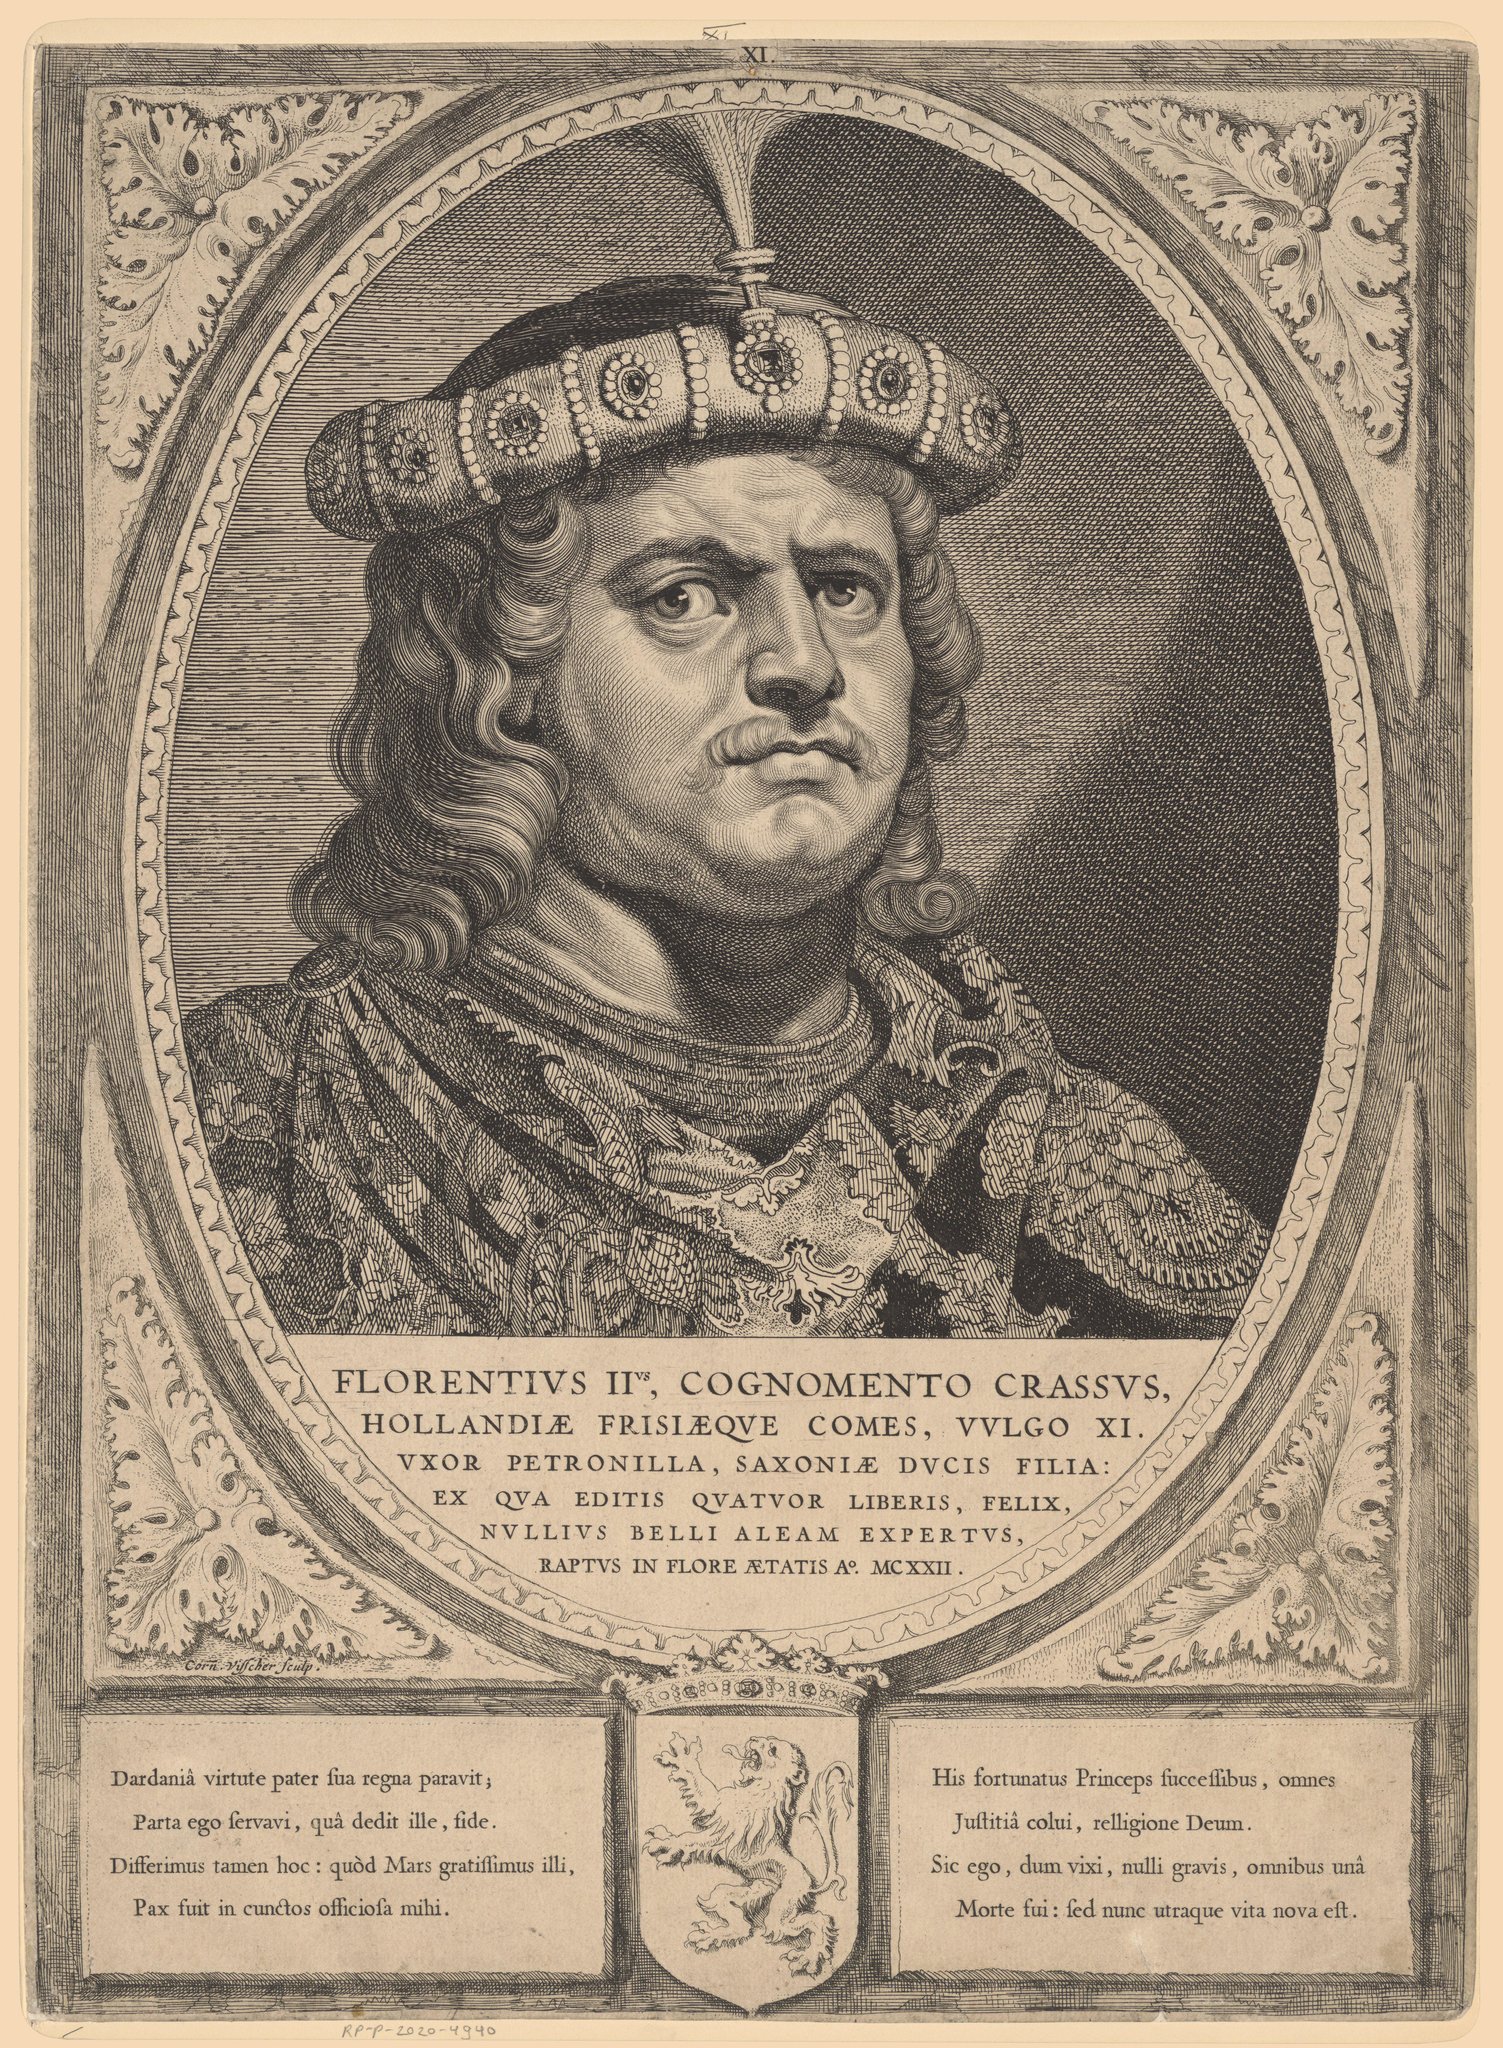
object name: print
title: Graven en gravinnen van Holland, Zeeland en West-Friesland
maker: cornelis visscher (ii)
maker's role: draughtsman, painter, print maker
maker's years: 1628-1658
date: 1650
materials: paper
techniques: engraving, etching, letterpress printing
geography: haarlem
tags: floris ii (count of holland), historical persons, ruler, sovereign, armorial bearing, heraldry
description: Midden boven genummerd: XI. Met onderschrift in het Latijn.